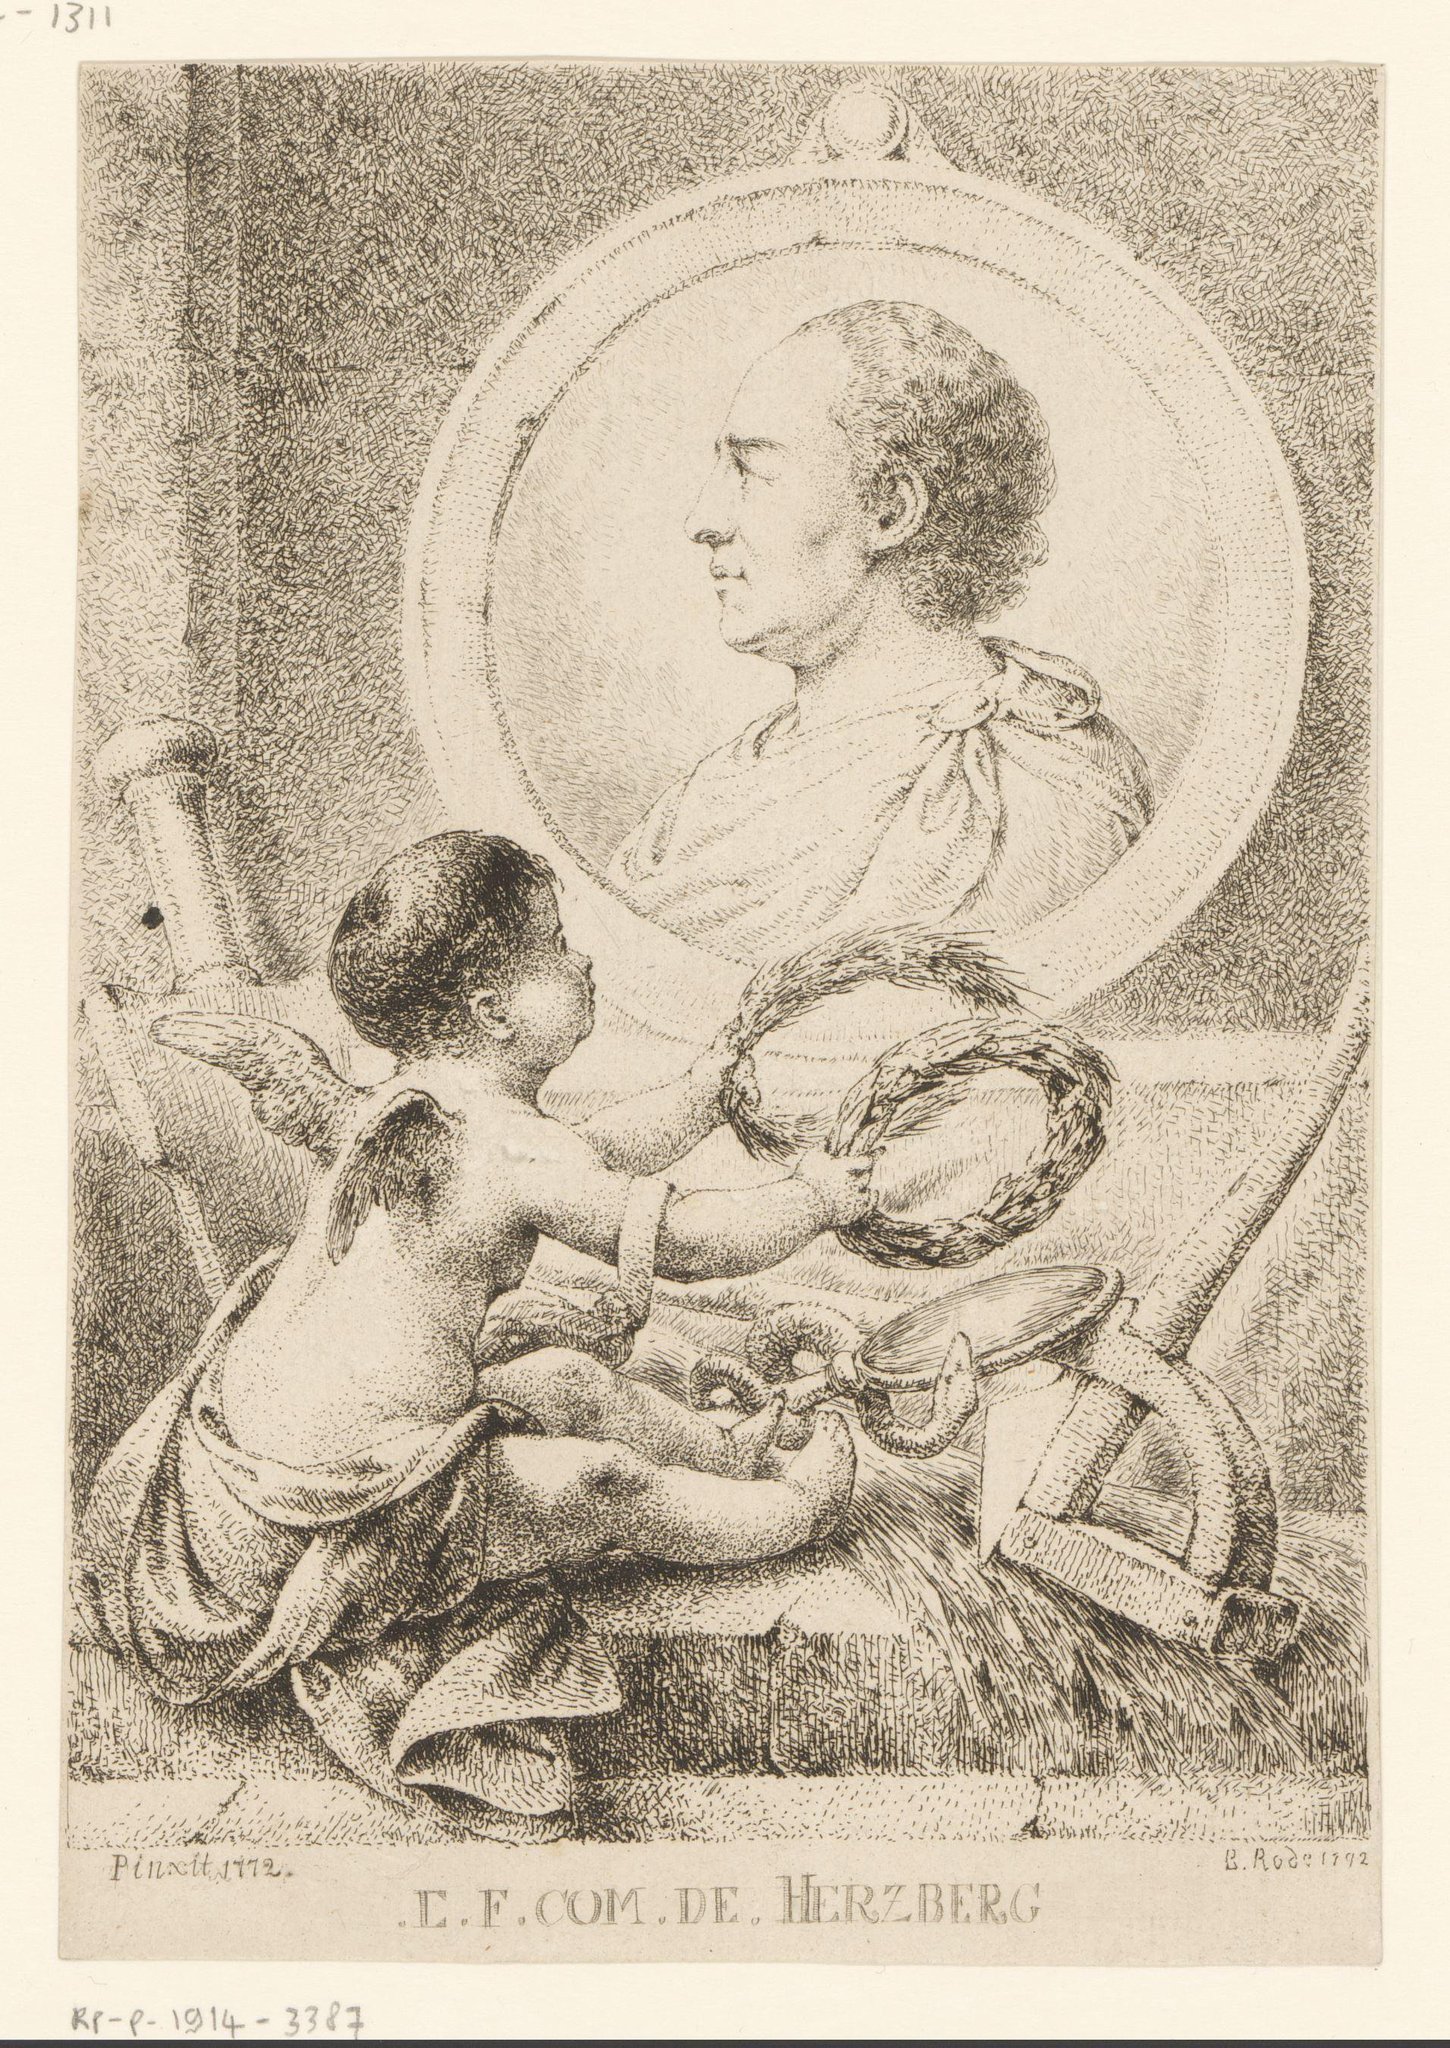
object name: print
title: Portret van Ewald Friedrich von Hertzberg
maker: bernhard rode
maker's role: artist, print maker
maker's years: 1725-1797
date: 1792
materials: paper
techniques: etching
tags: poland, berlin, ewald friedrich von hertzberg (graaf), wisdom; 'sapienza', 'sapienza humana', 'sapienza vera' (ripa), historical persons, agricultural implements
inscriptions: collector's mark: Lugt 2228